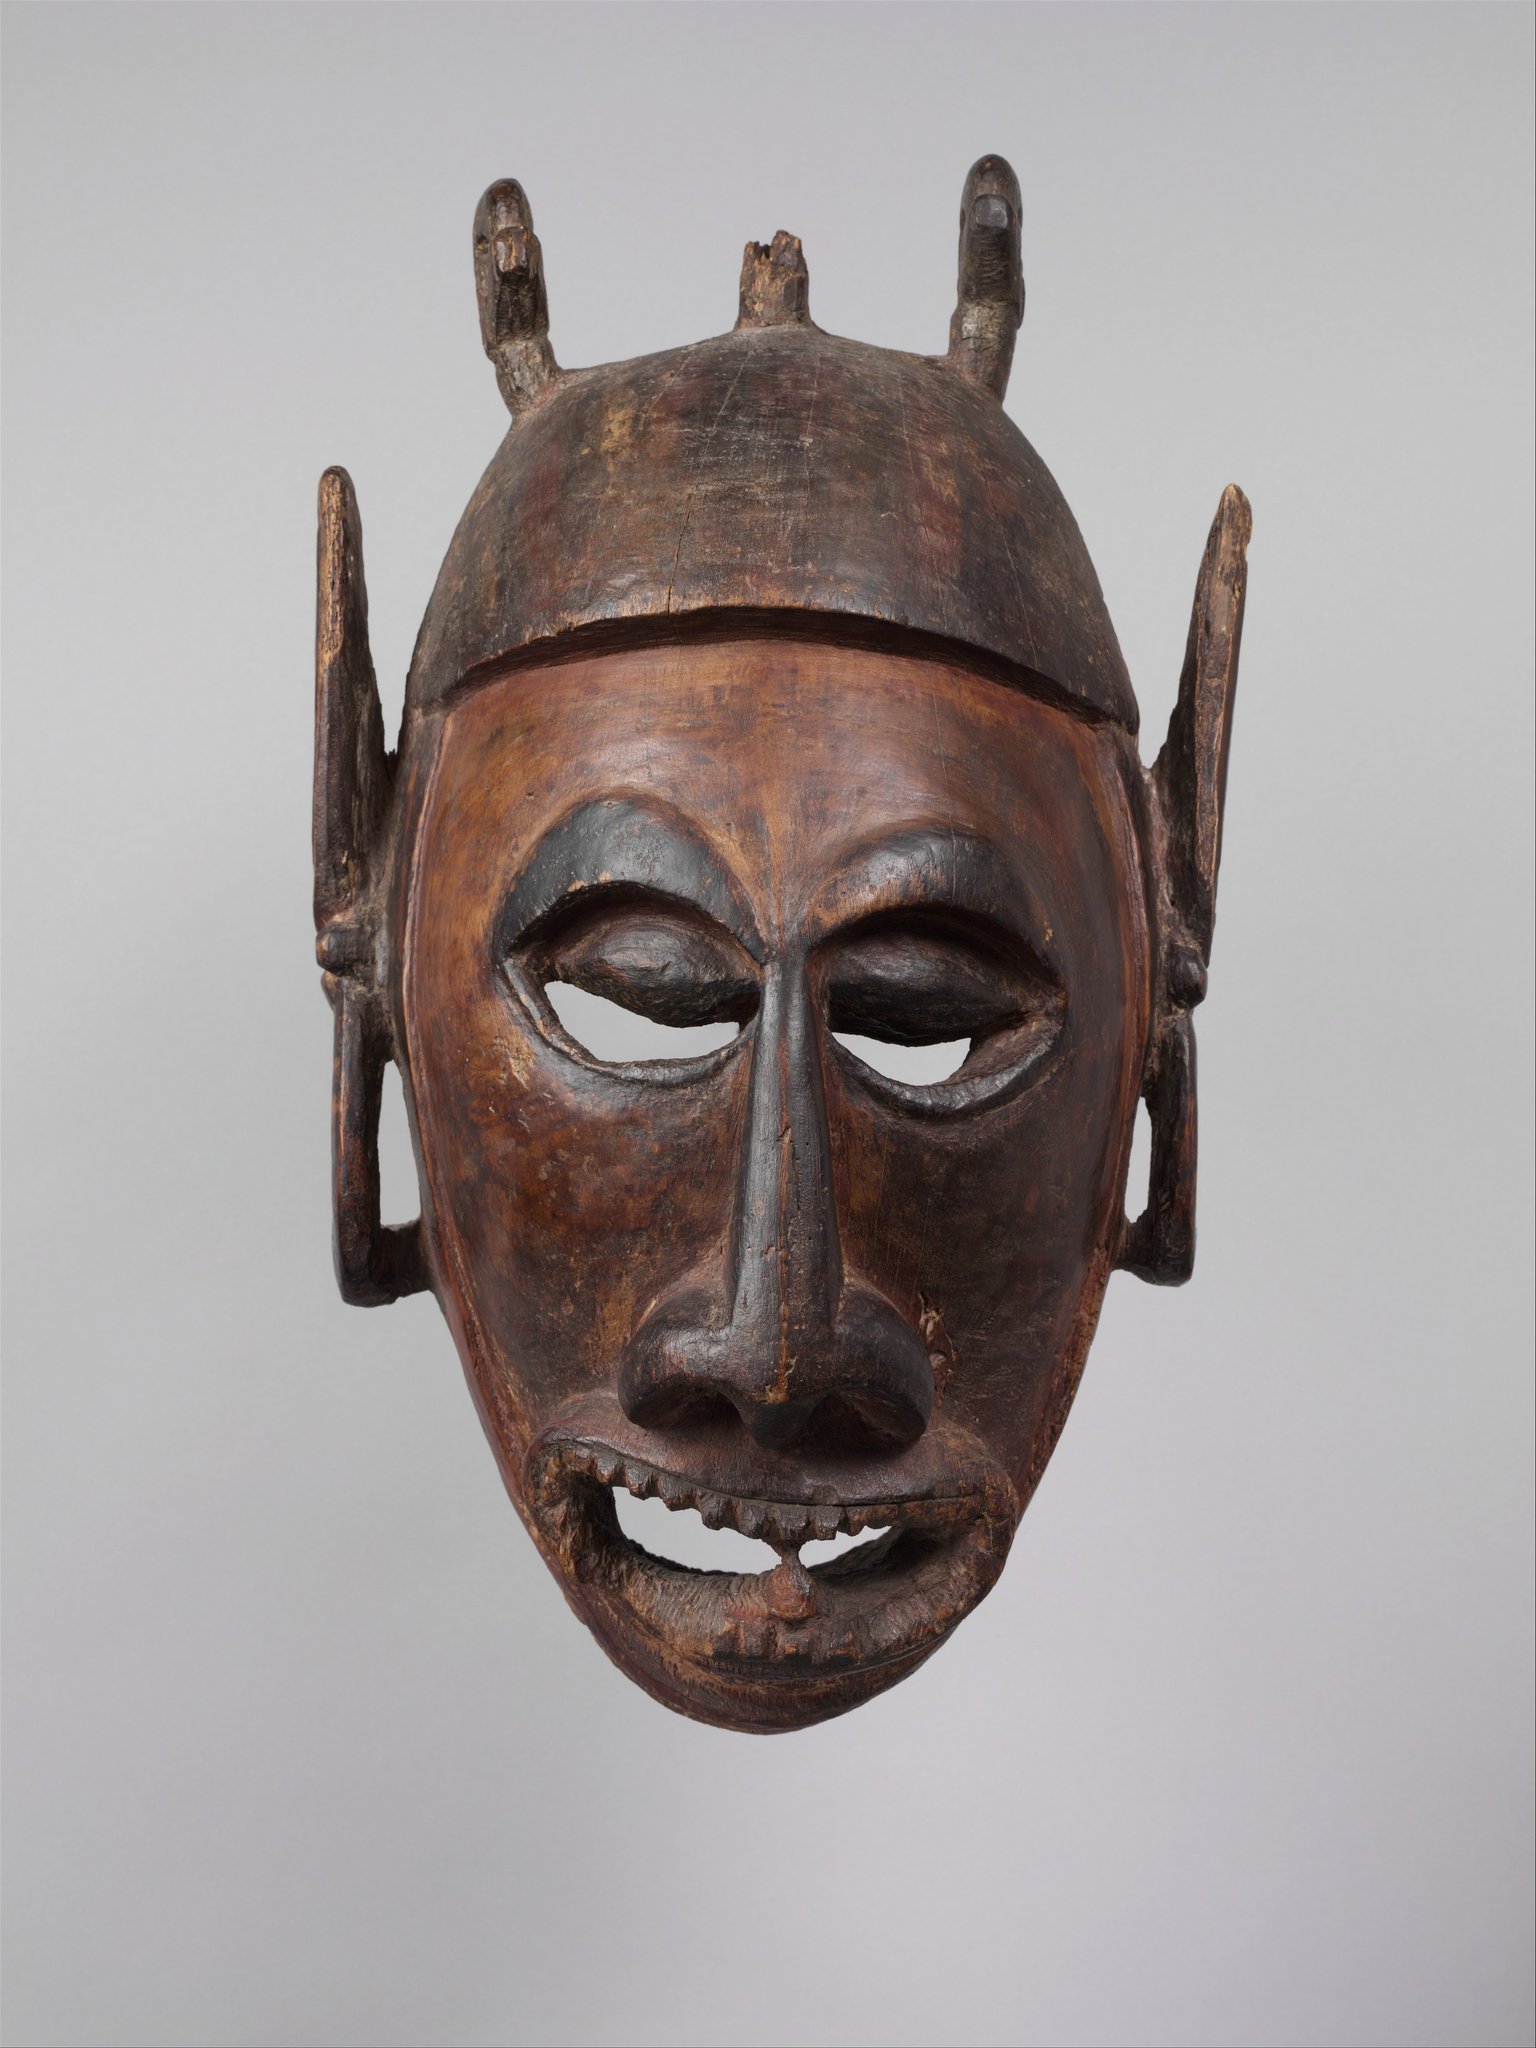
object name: mask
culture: siassi islands or umboi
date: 1801-1900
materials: paint, wood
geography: papua new guinea